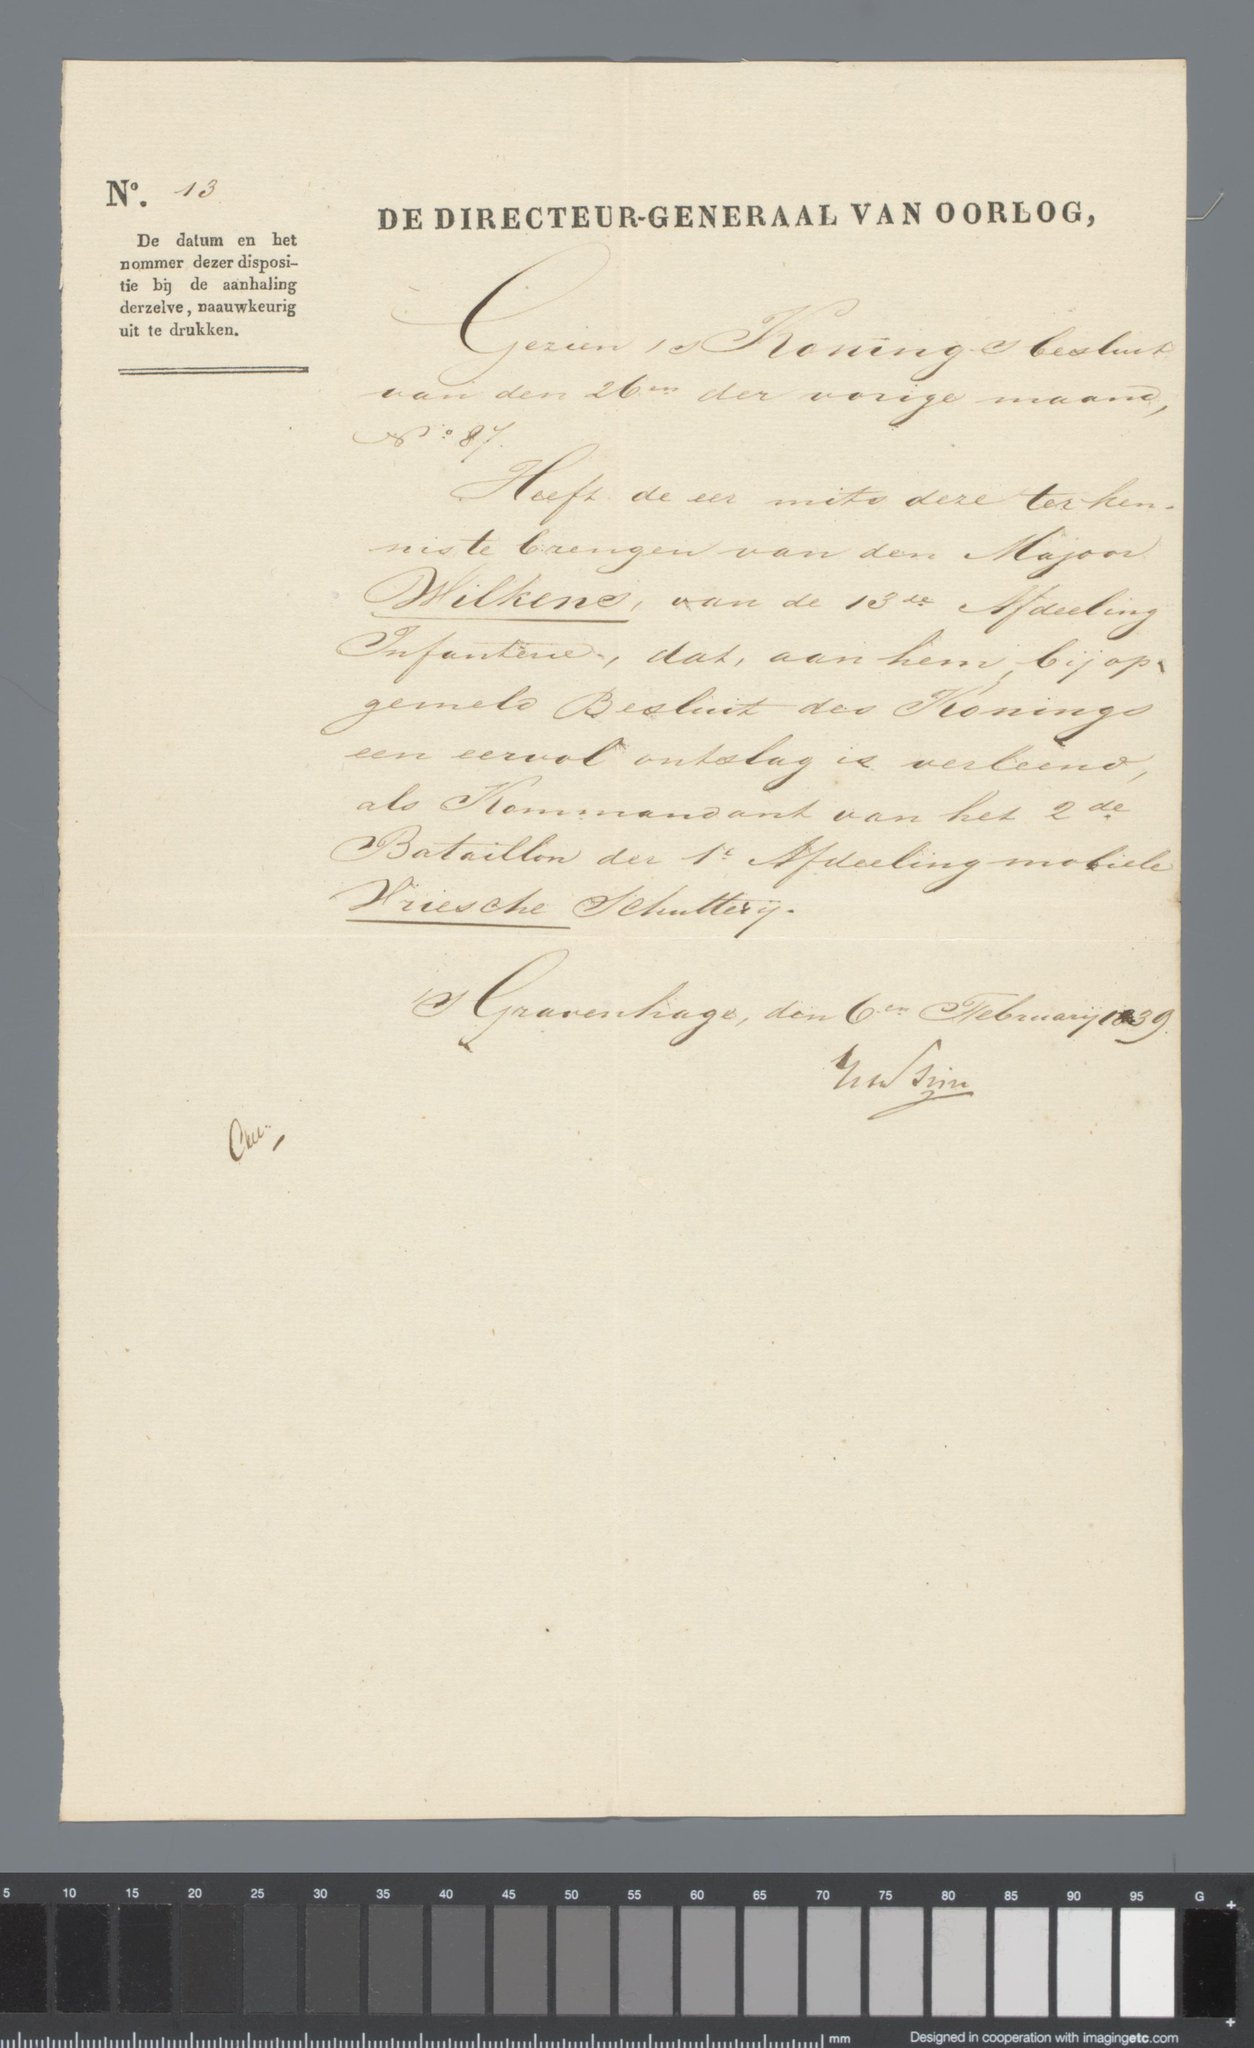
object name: letter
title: Eervol ontslag ontleend aan J.D.B. Wilkens als commandant van de 2e bataljon van de 1e Afdeling Mobiele Friese Schutterij, 6 februari 1839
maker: directeur-generaal van oorlog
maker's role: official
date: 1839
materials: paper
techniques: handwriting, letterpress printing, pen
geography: netherlands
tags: military service, netherlands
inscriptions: number: ‘11198’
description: Onderdeel van een groep van documenten betreffende de staat van dienst, benoemingen, enz. van Luitenant Kolonel van de Infanterie J.D.B. Wilkens. Behorende bij de schenking van het geschilderde portret.